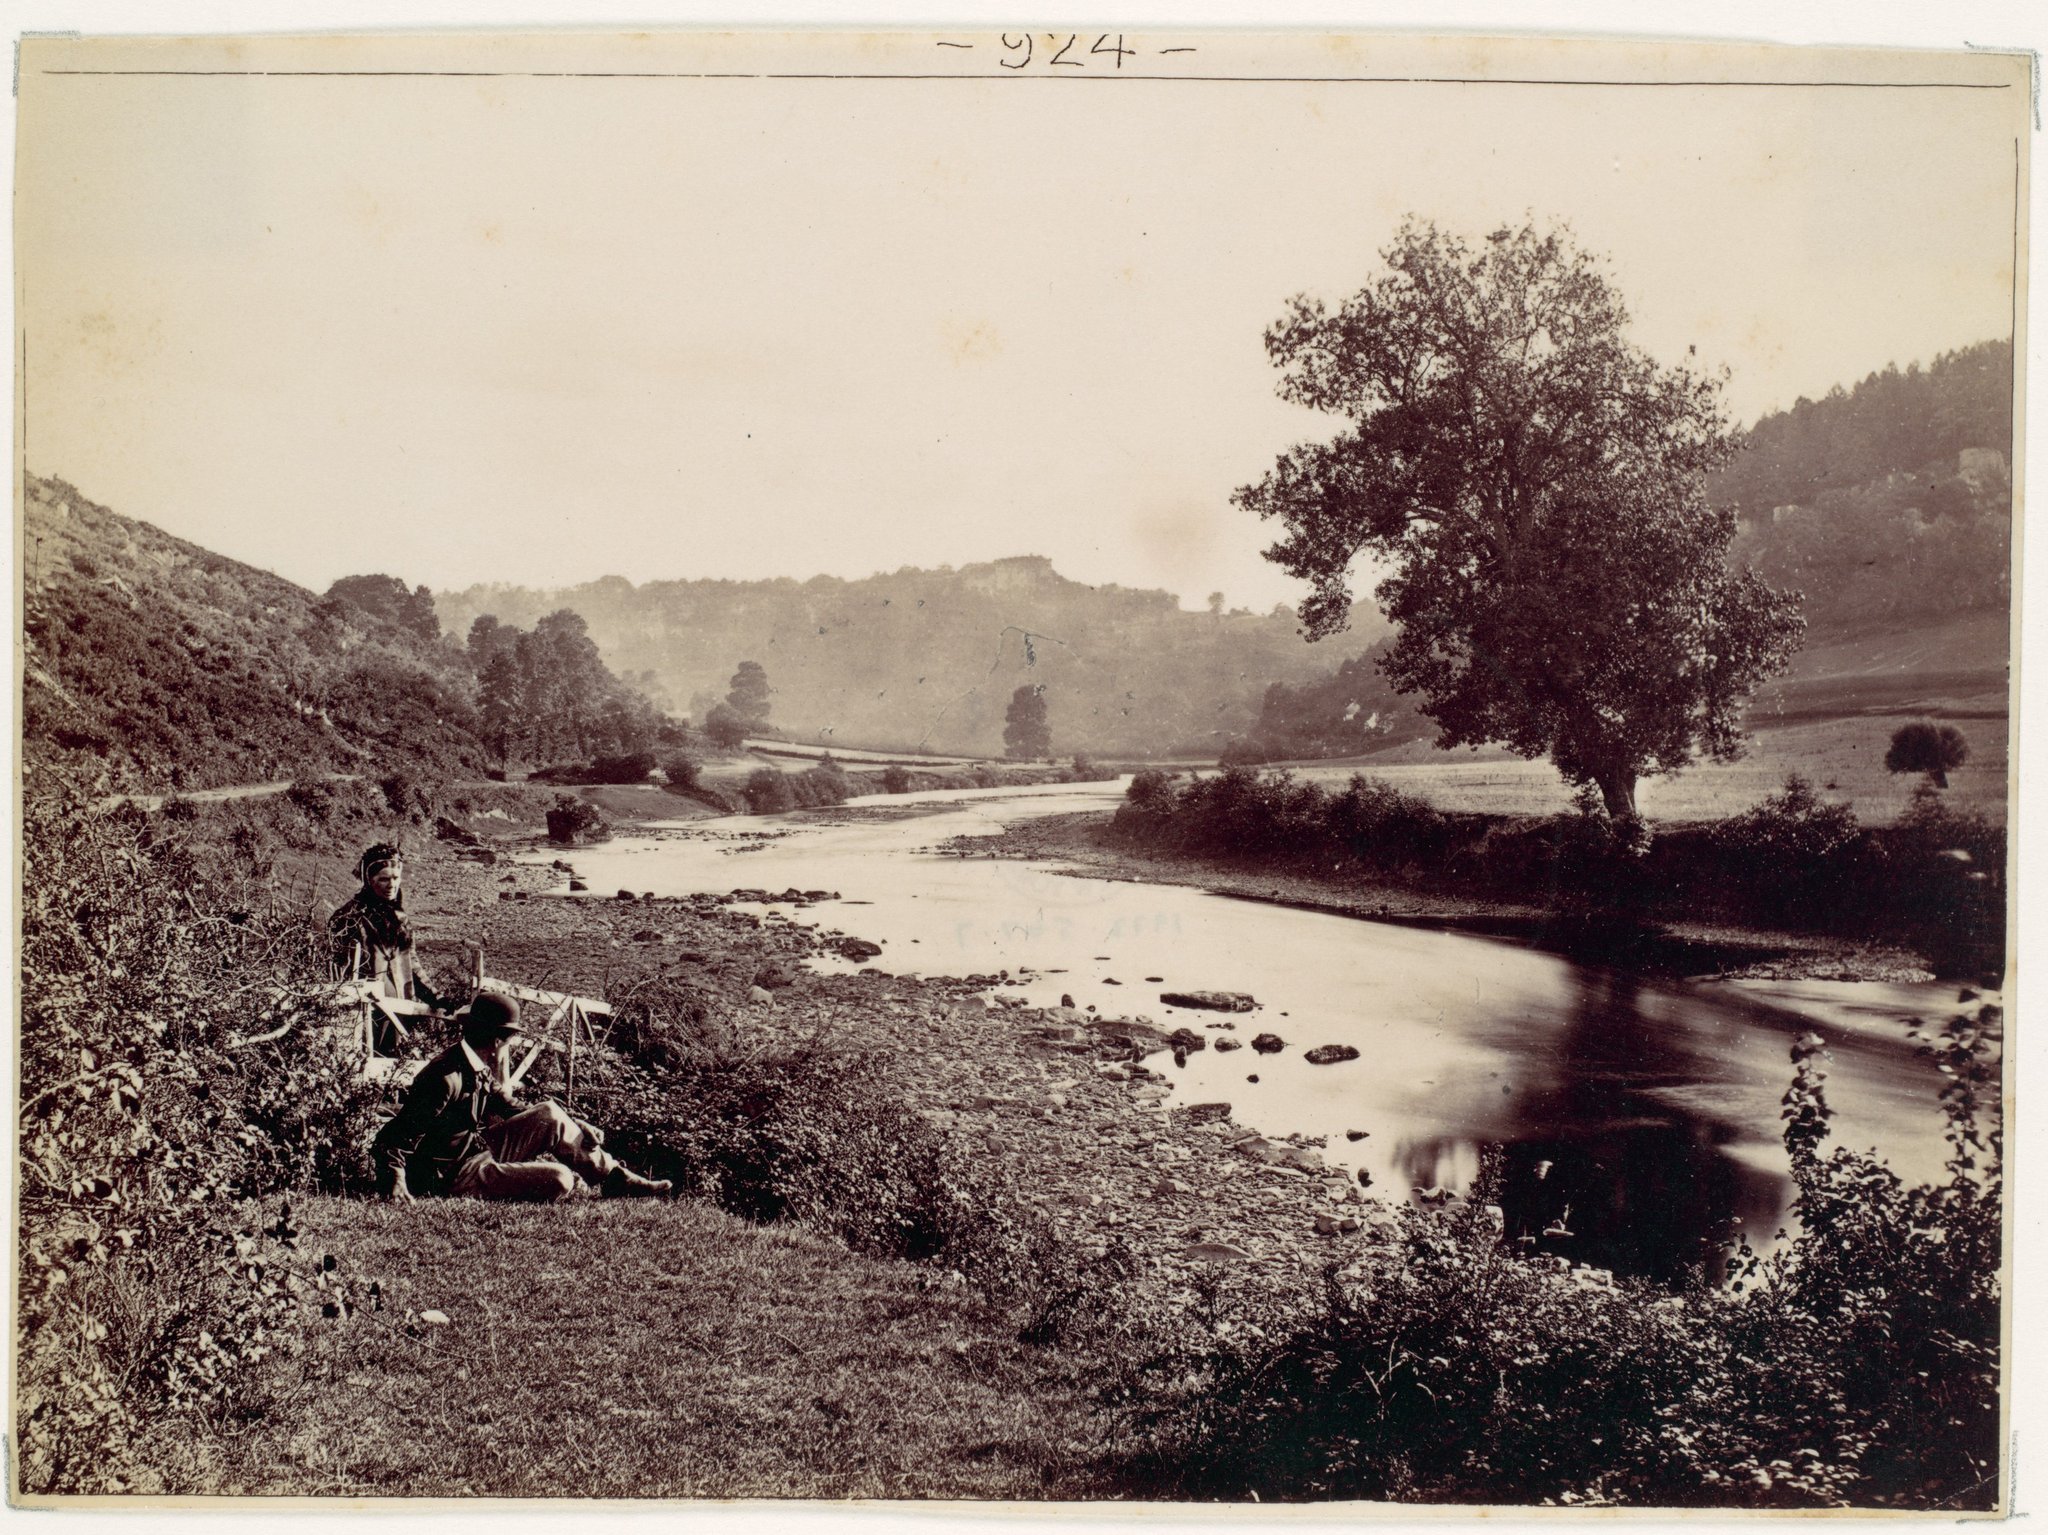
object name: photograph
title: The Wye and Symond's Yat. From Rocklands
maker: francis bedford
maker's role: artist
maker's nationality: british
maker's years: 1816-1894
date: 1870-1879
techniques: albumen silver print, glass negative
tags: rivers,landscapes